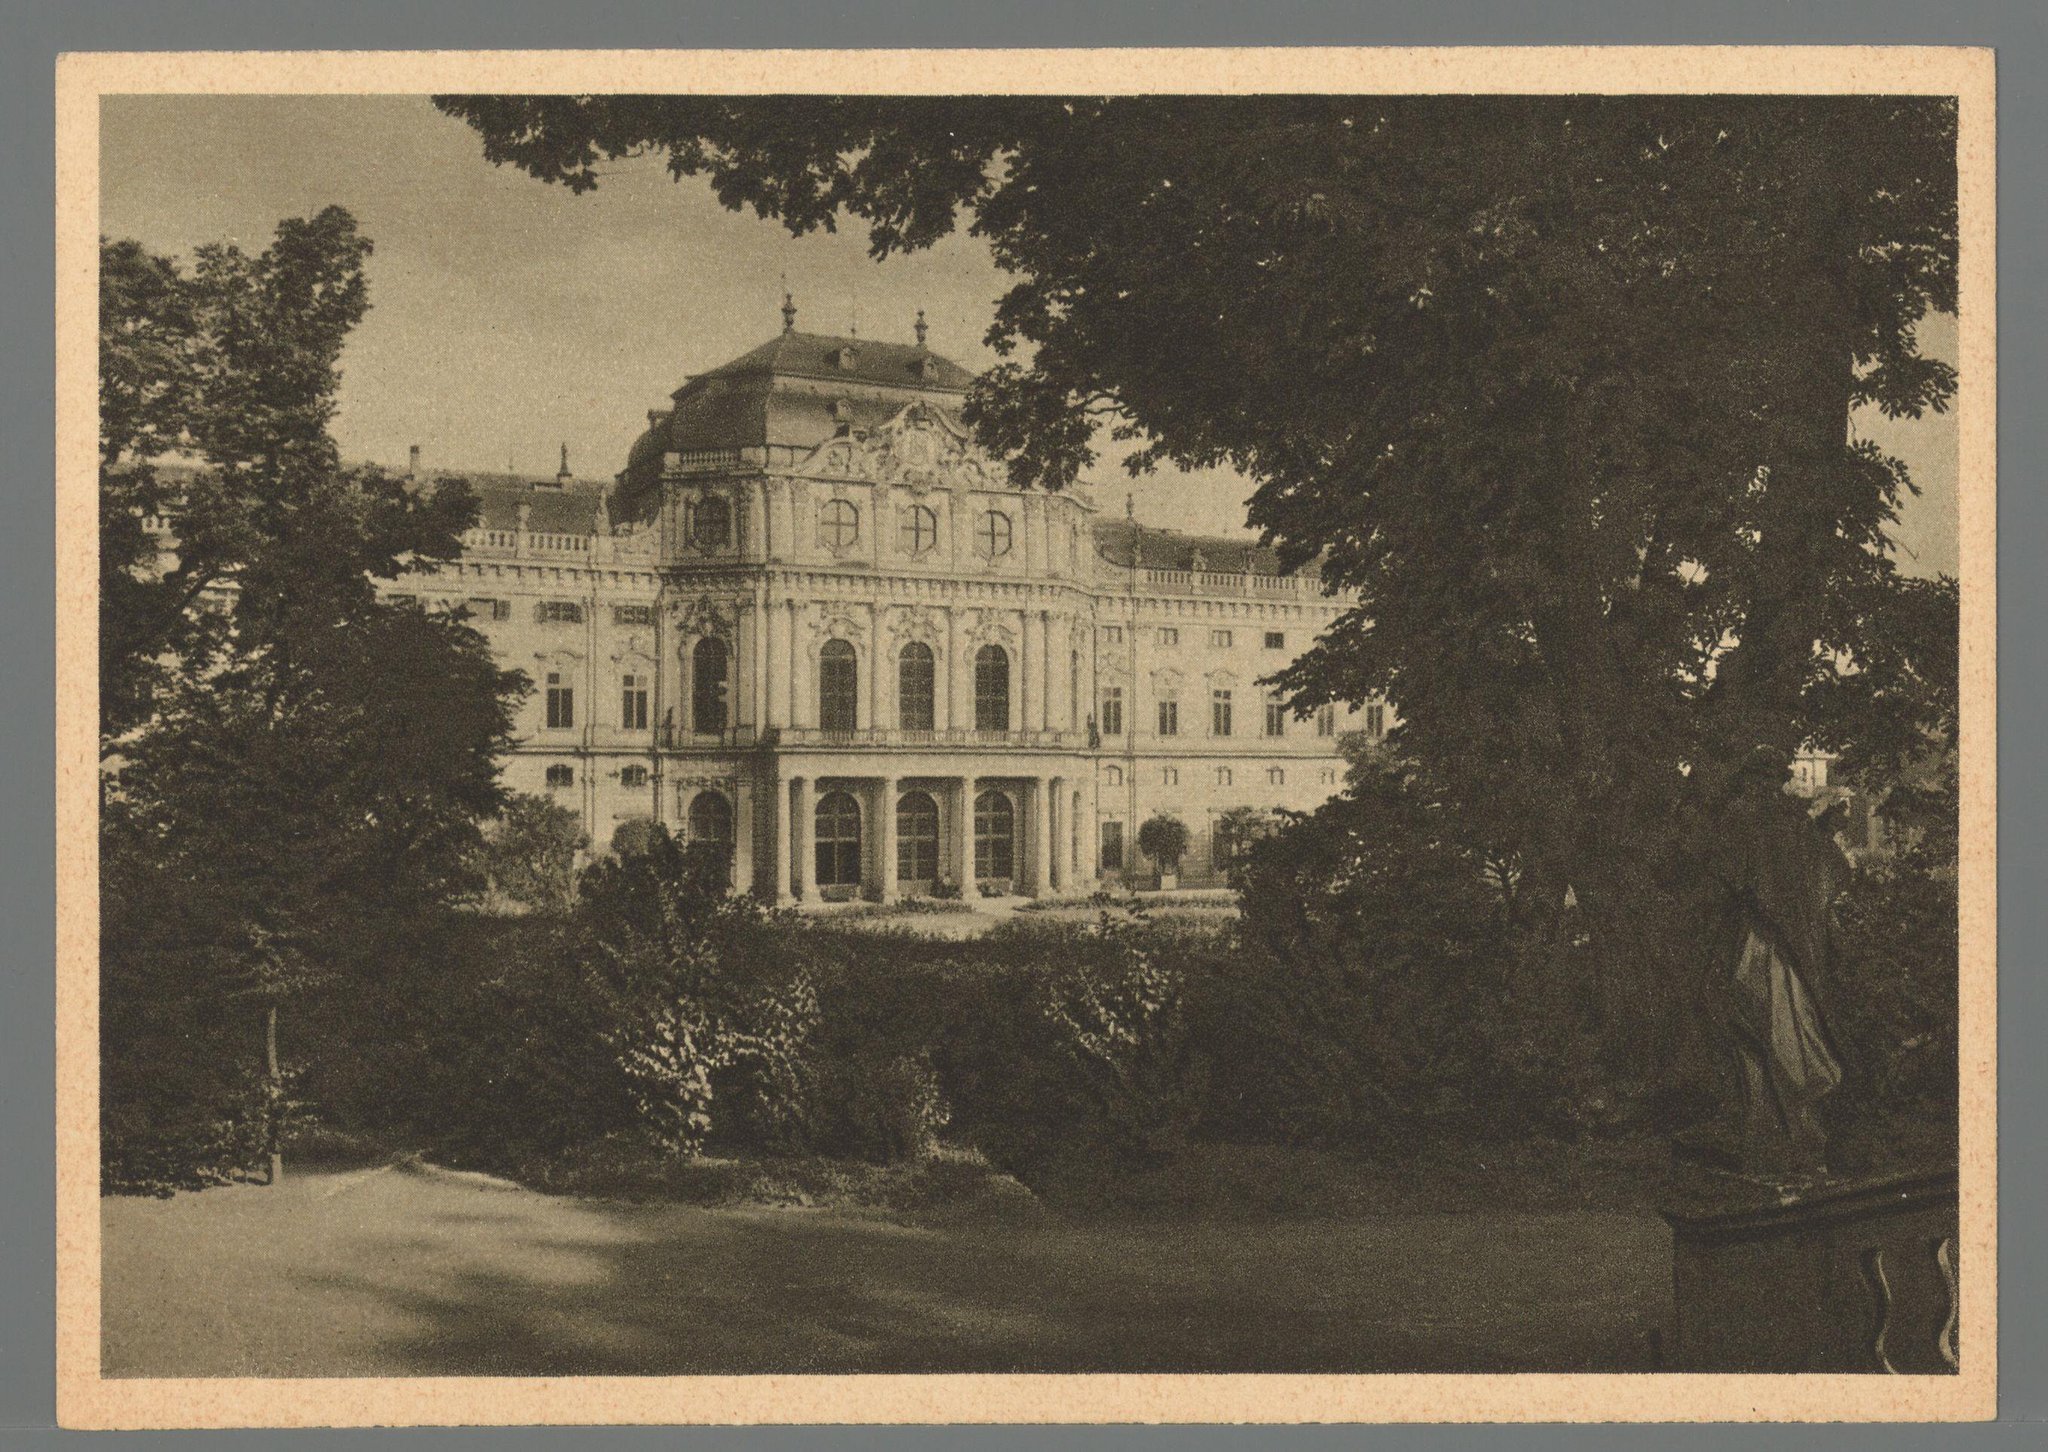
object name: photomechanical print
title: Residenz Würzburg. Gartenseite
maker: Anonymous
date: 1905-1950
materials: cardboard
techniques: rotogravure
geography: würzburg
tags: garden, palace